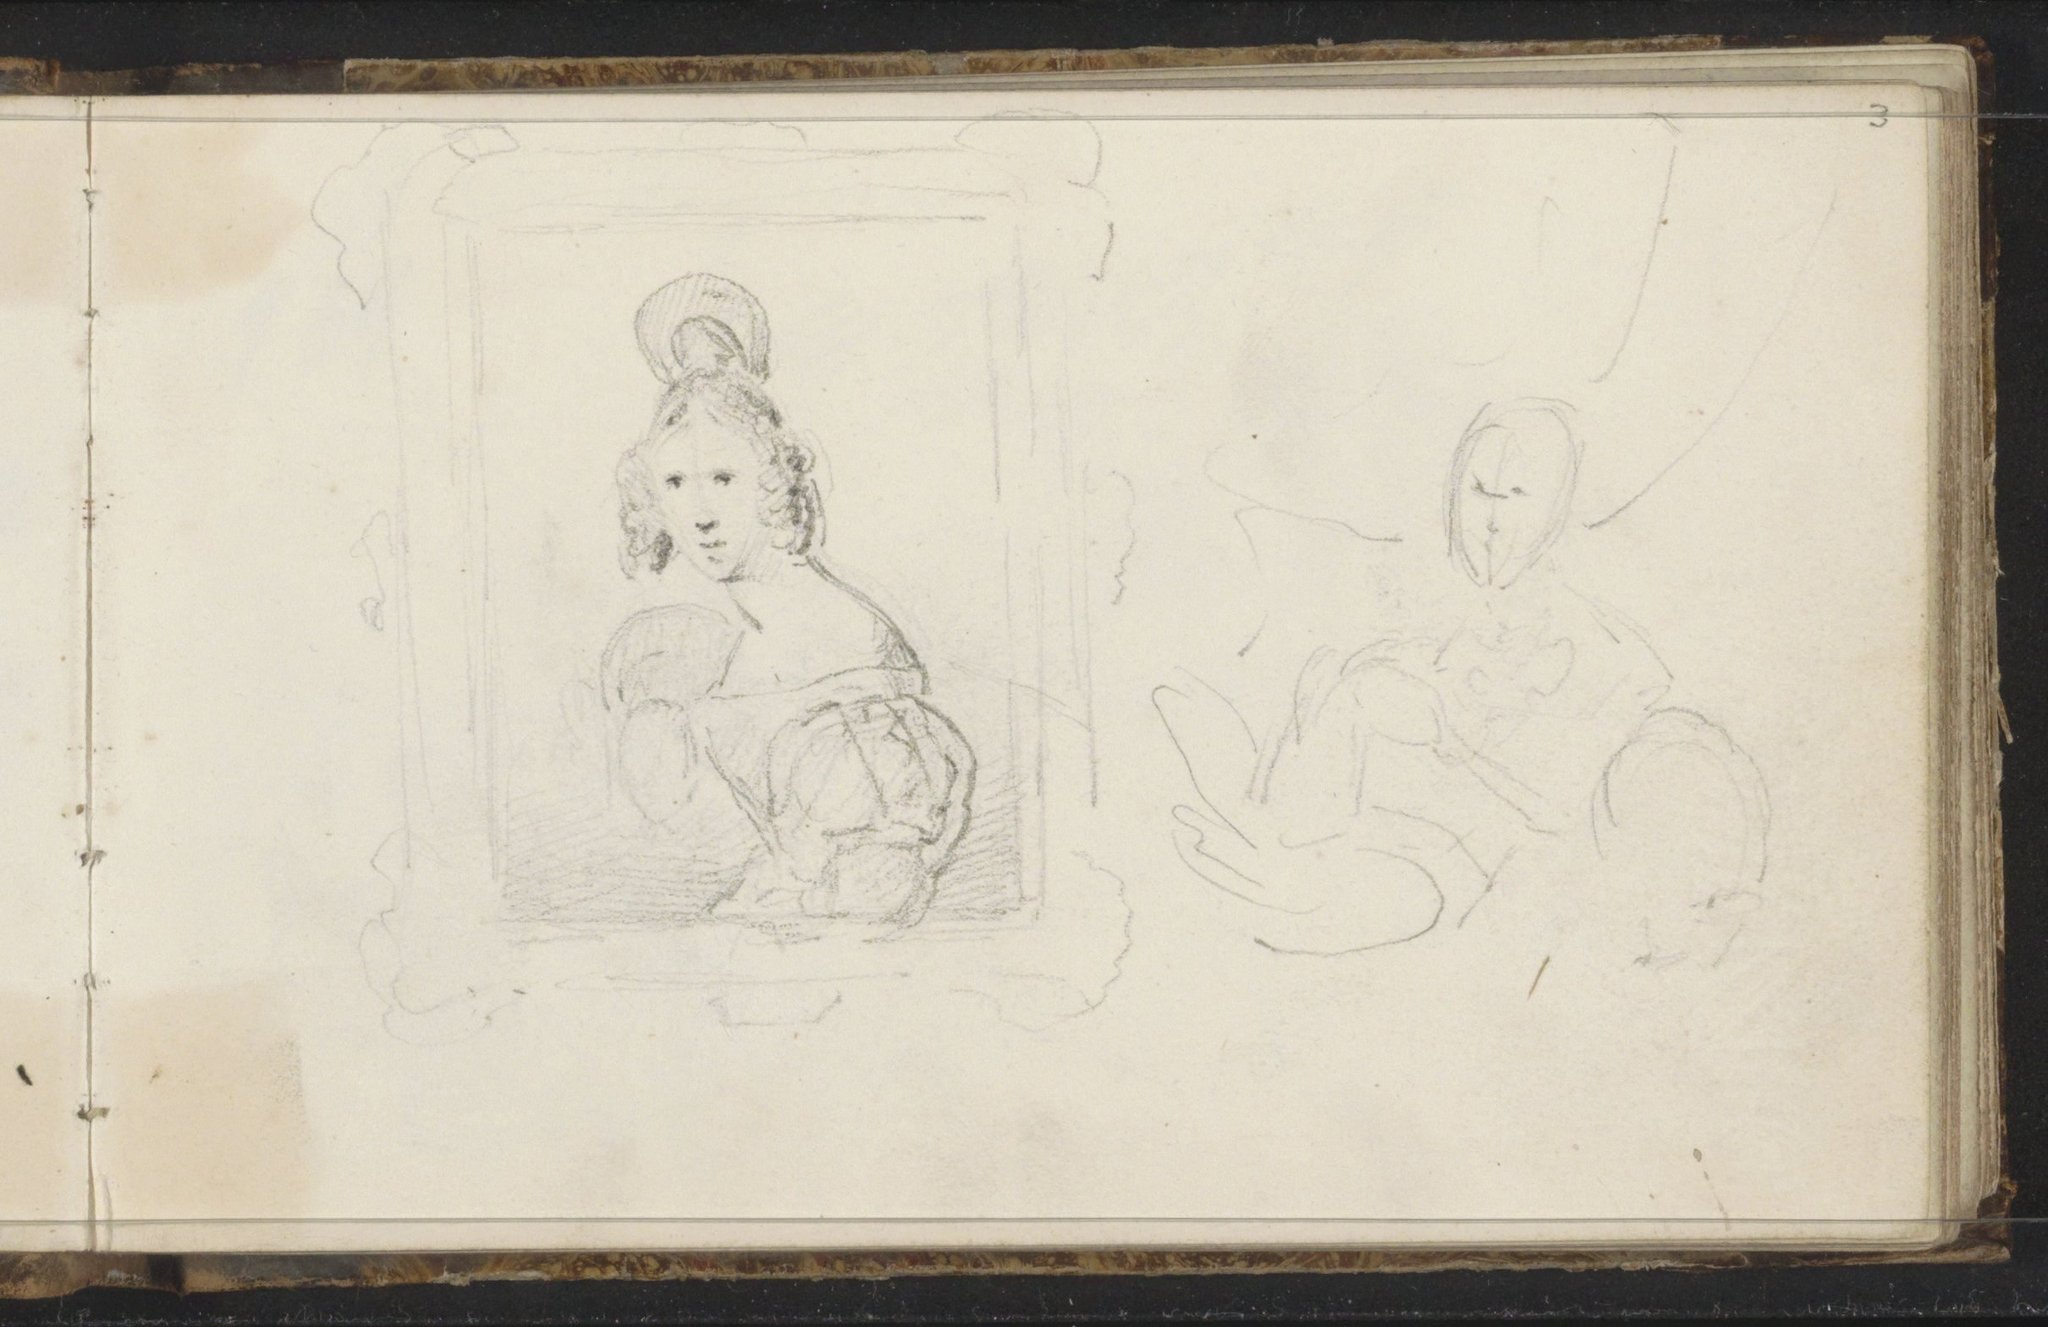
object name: sketchbook leaf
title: Portret van een vrouw met waaier in een lijst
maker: willem hendrik schmidt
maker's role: draughtsman, painter, print maker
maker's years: 1809-1849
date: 1819-1849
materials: paper, pencil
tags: anonymous historical person portrayed, frame of painting, etc.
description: Tevens een figuurstudie. Blad 3 recto uit een schetsboek met 60 bladen.